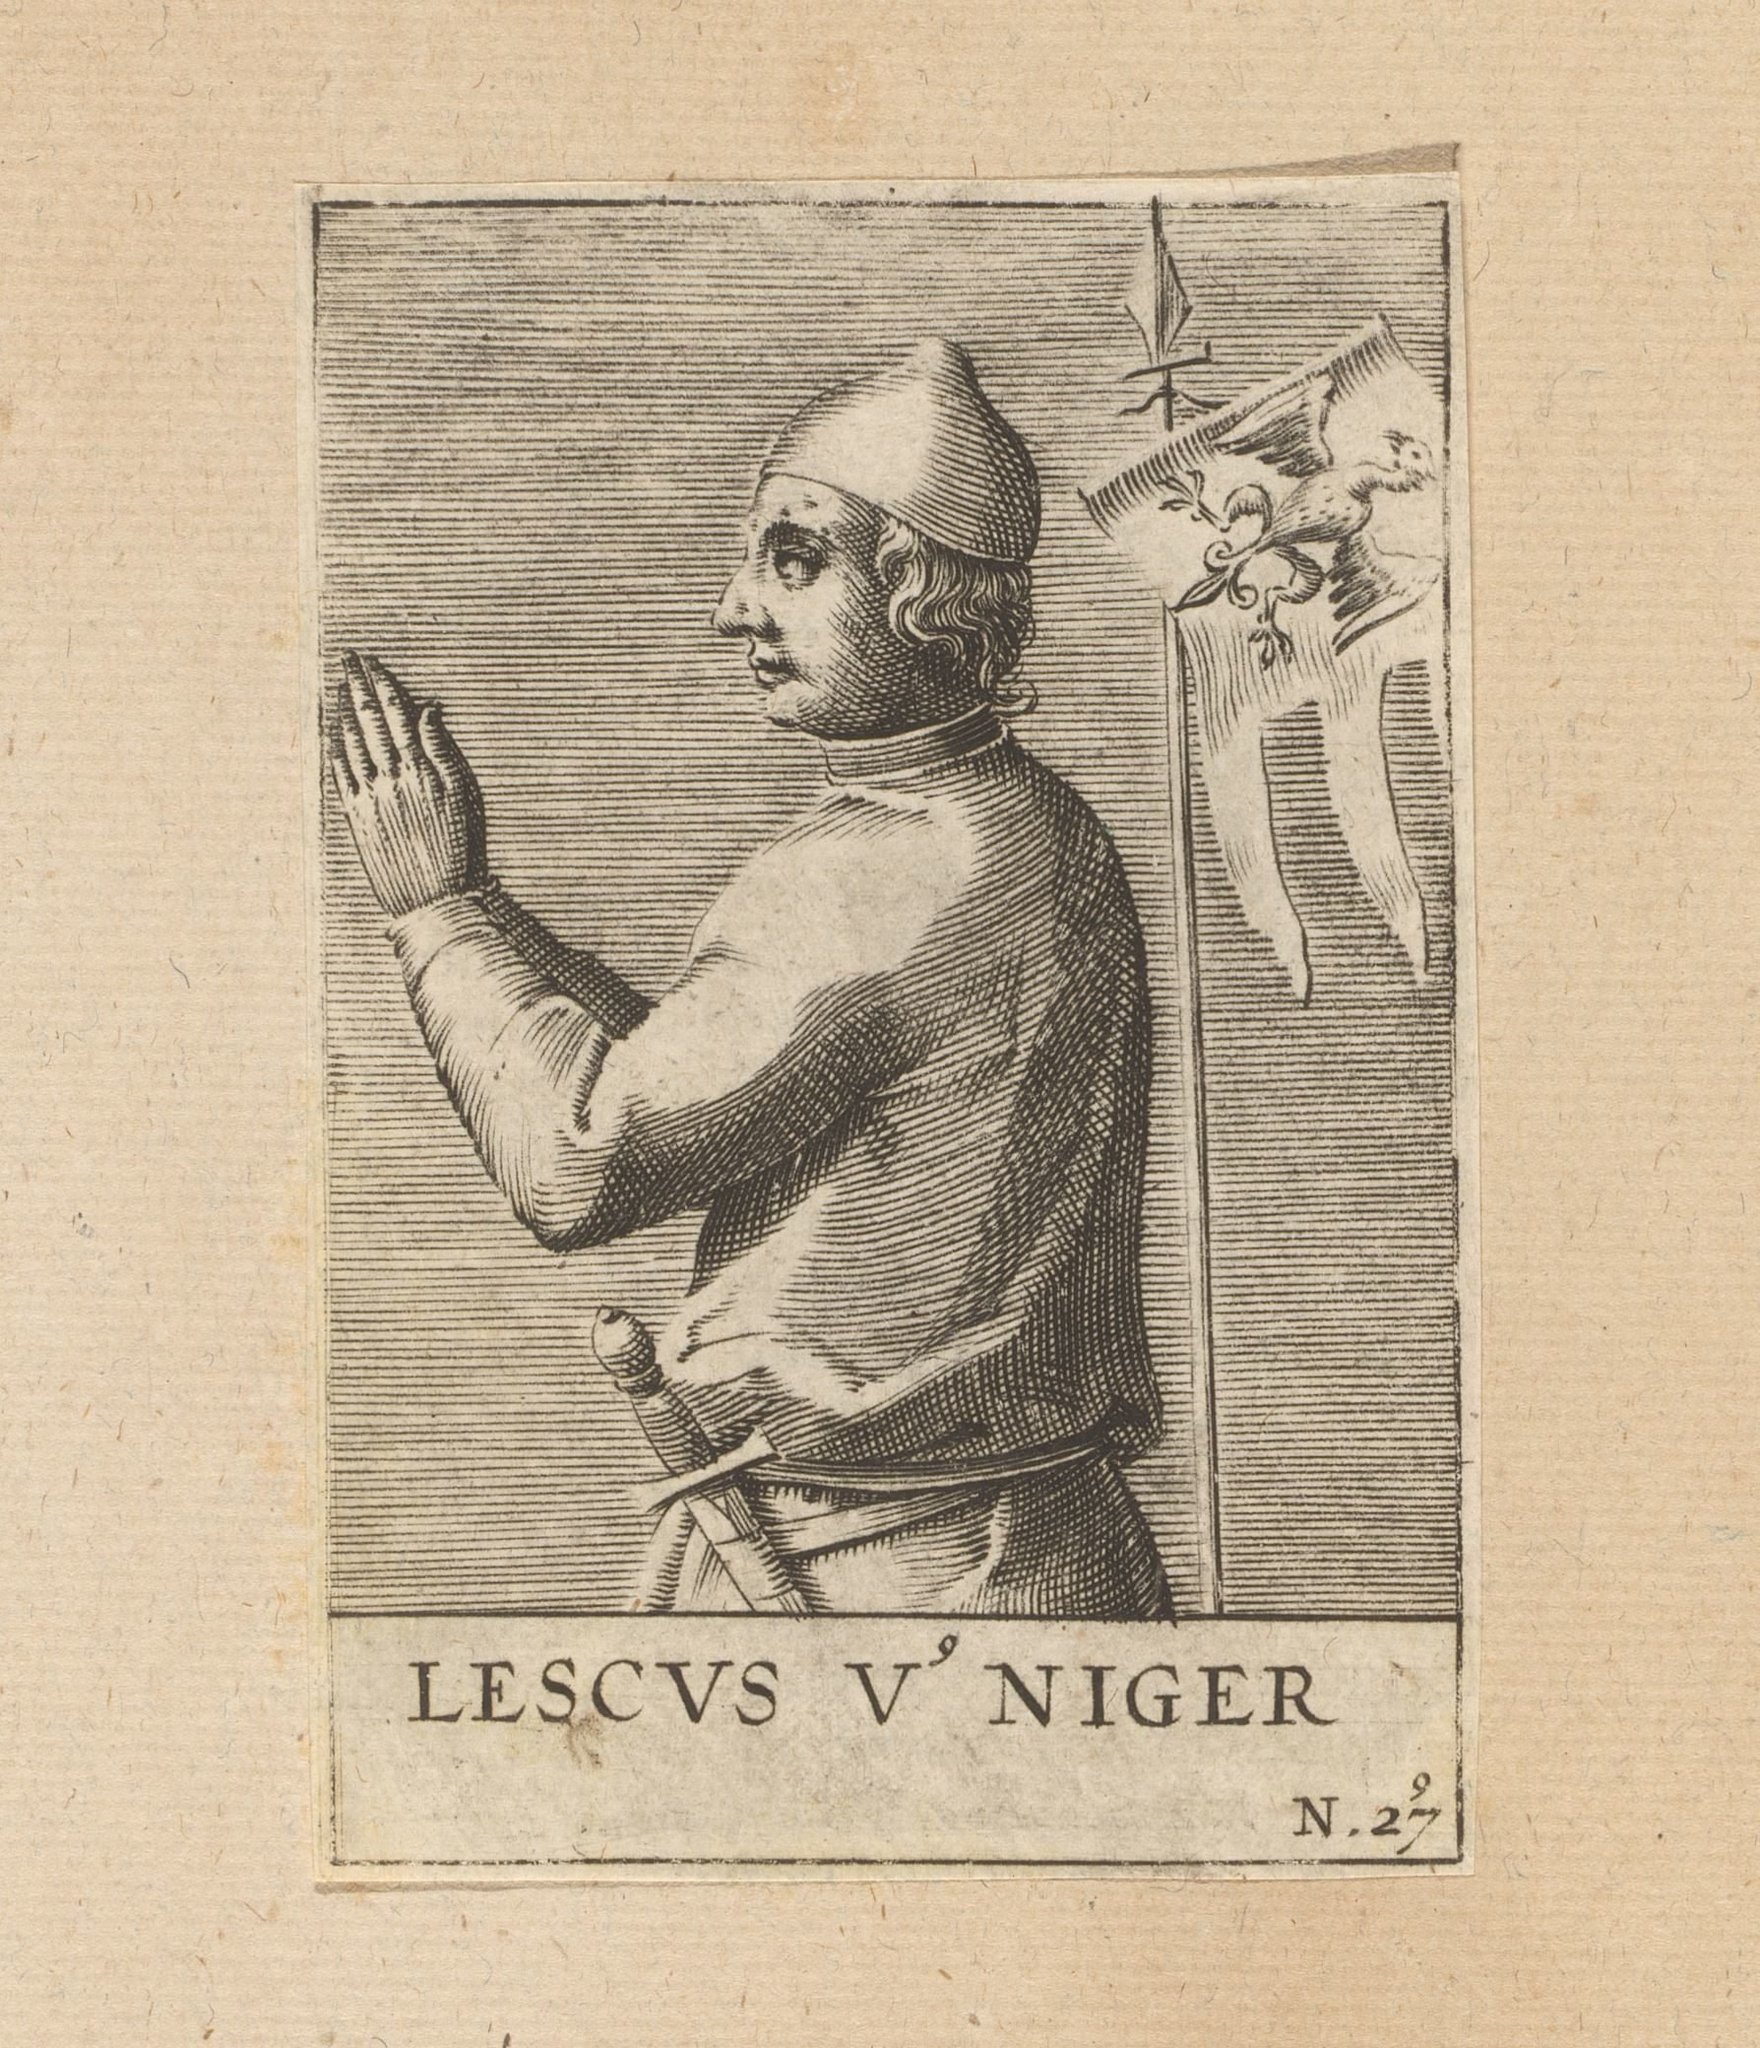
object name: book illustration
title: Portret van Leszek II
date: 1574-1594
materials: paper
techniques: woodcut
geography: cologne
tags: historical persons, ruler, sovereign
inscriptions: collector's mark: Lugt 240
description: Prent gebruikt in: Mylius, Arnold. Principum et Regum Polonorum Imagines ad Vivum Expressae (...). Keulen: Gottfried von Kempen, 1594.